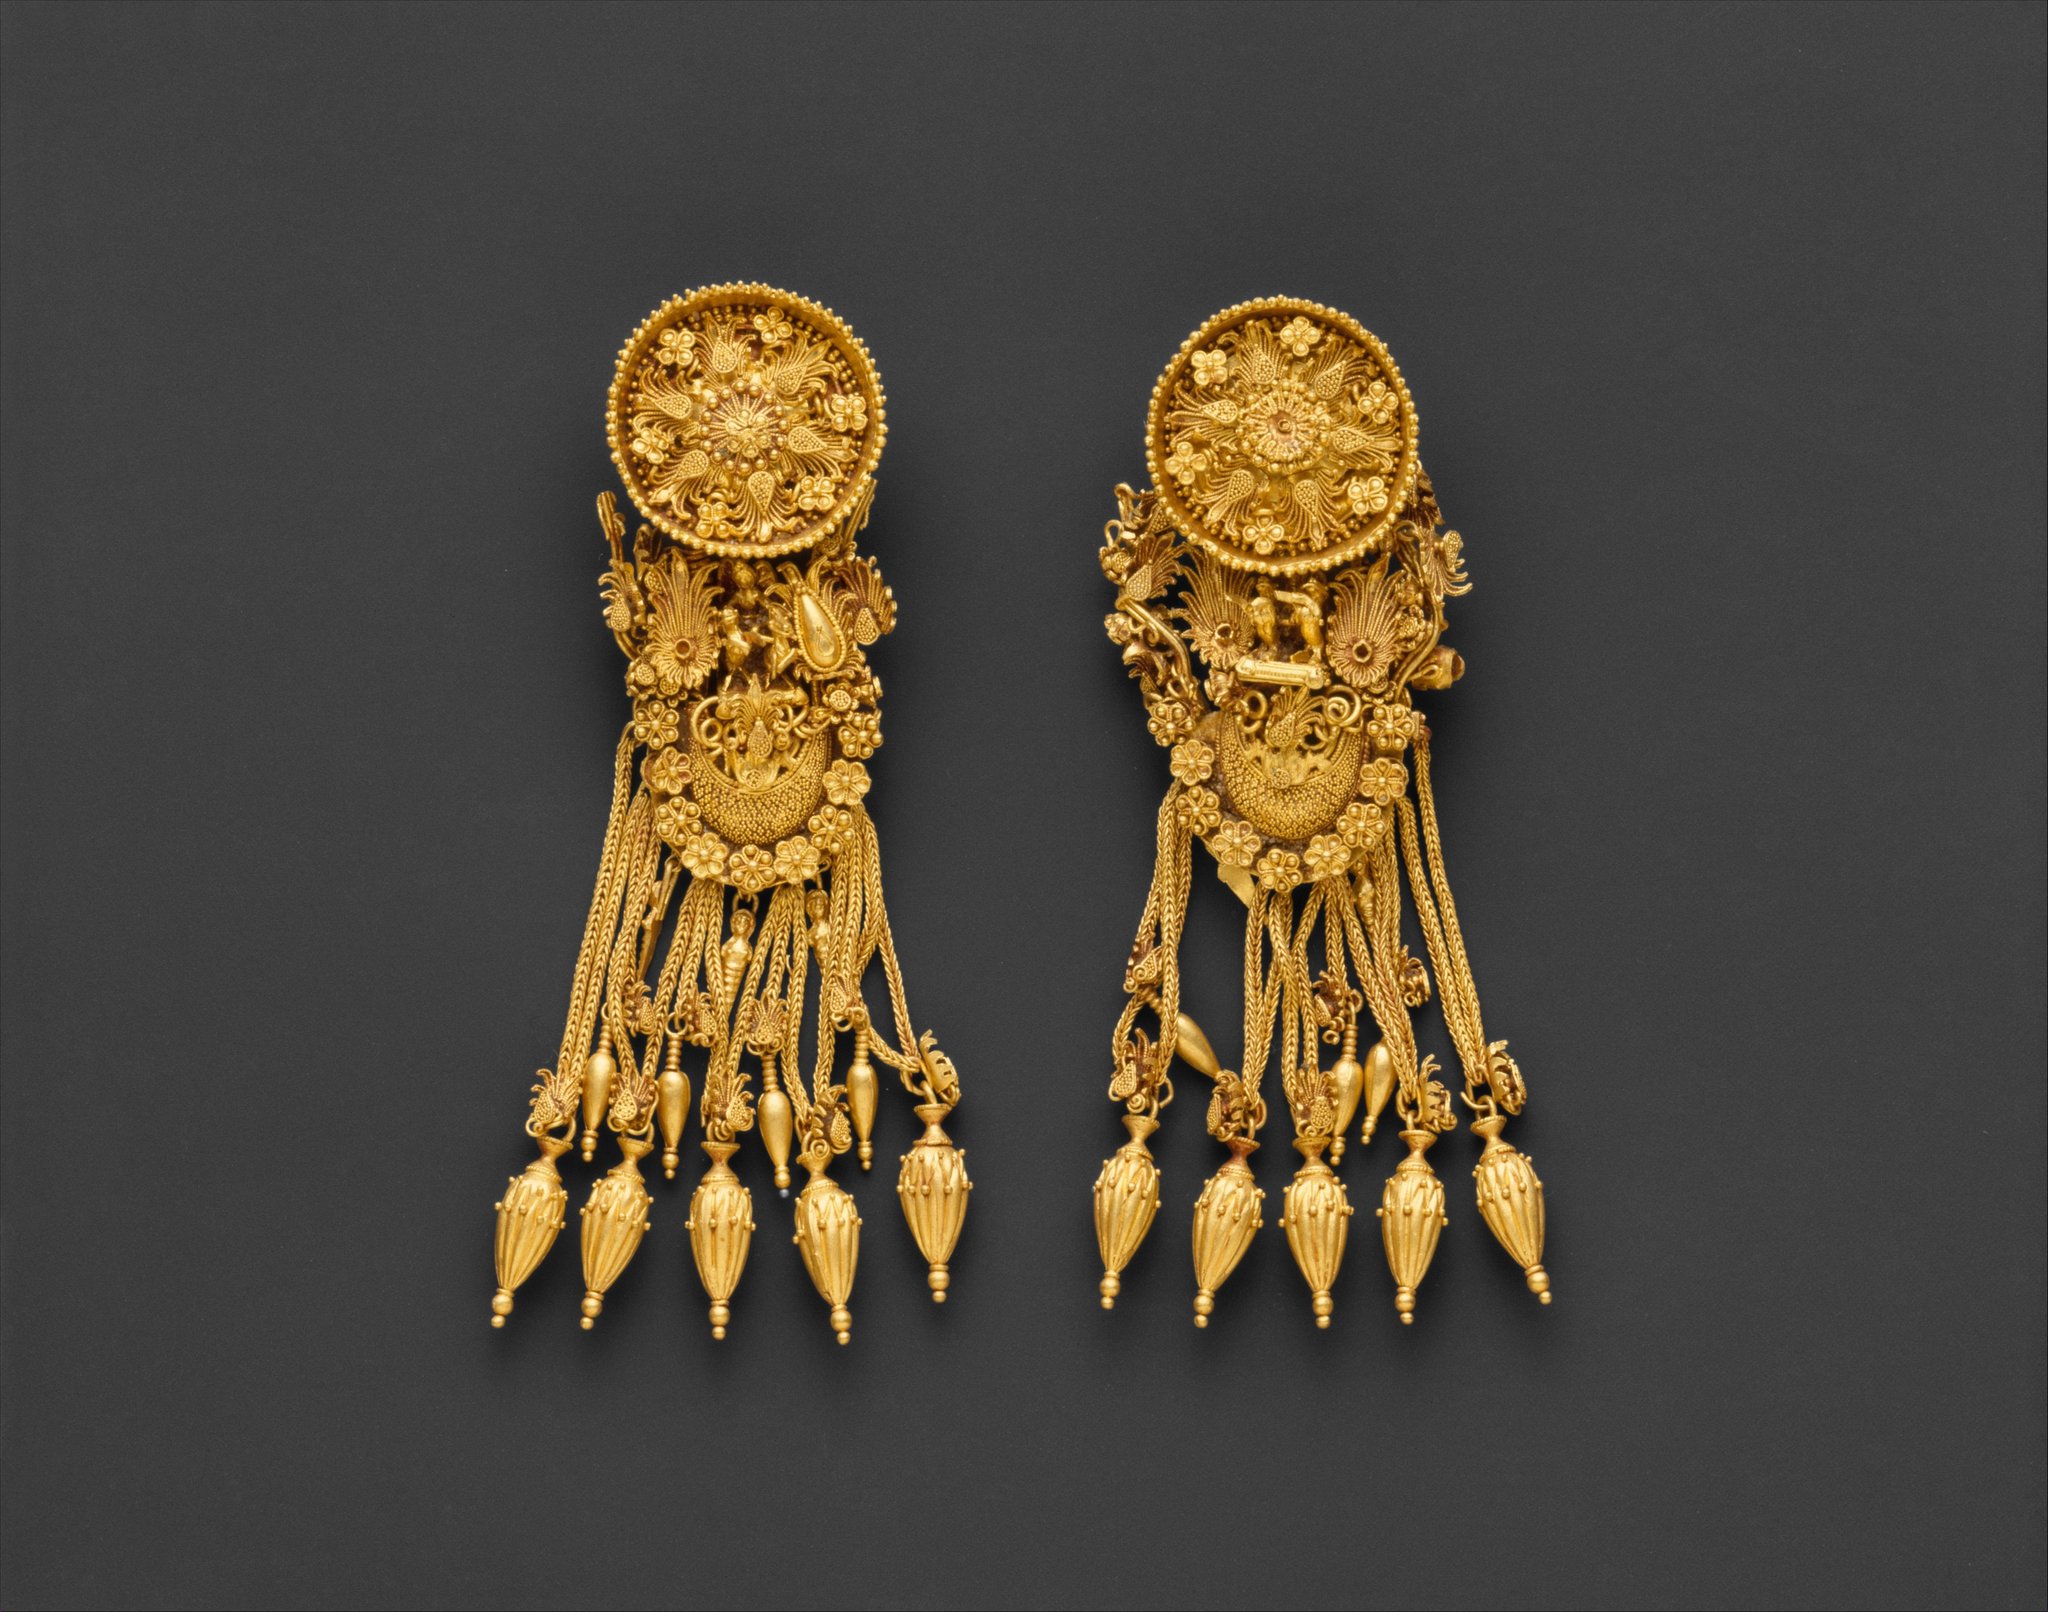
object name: earring with disc and boat shaped pendant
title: Gold earrings with disk and boat-shaped pendant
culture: east greek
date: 300 BCE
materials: gold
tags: nike,horses